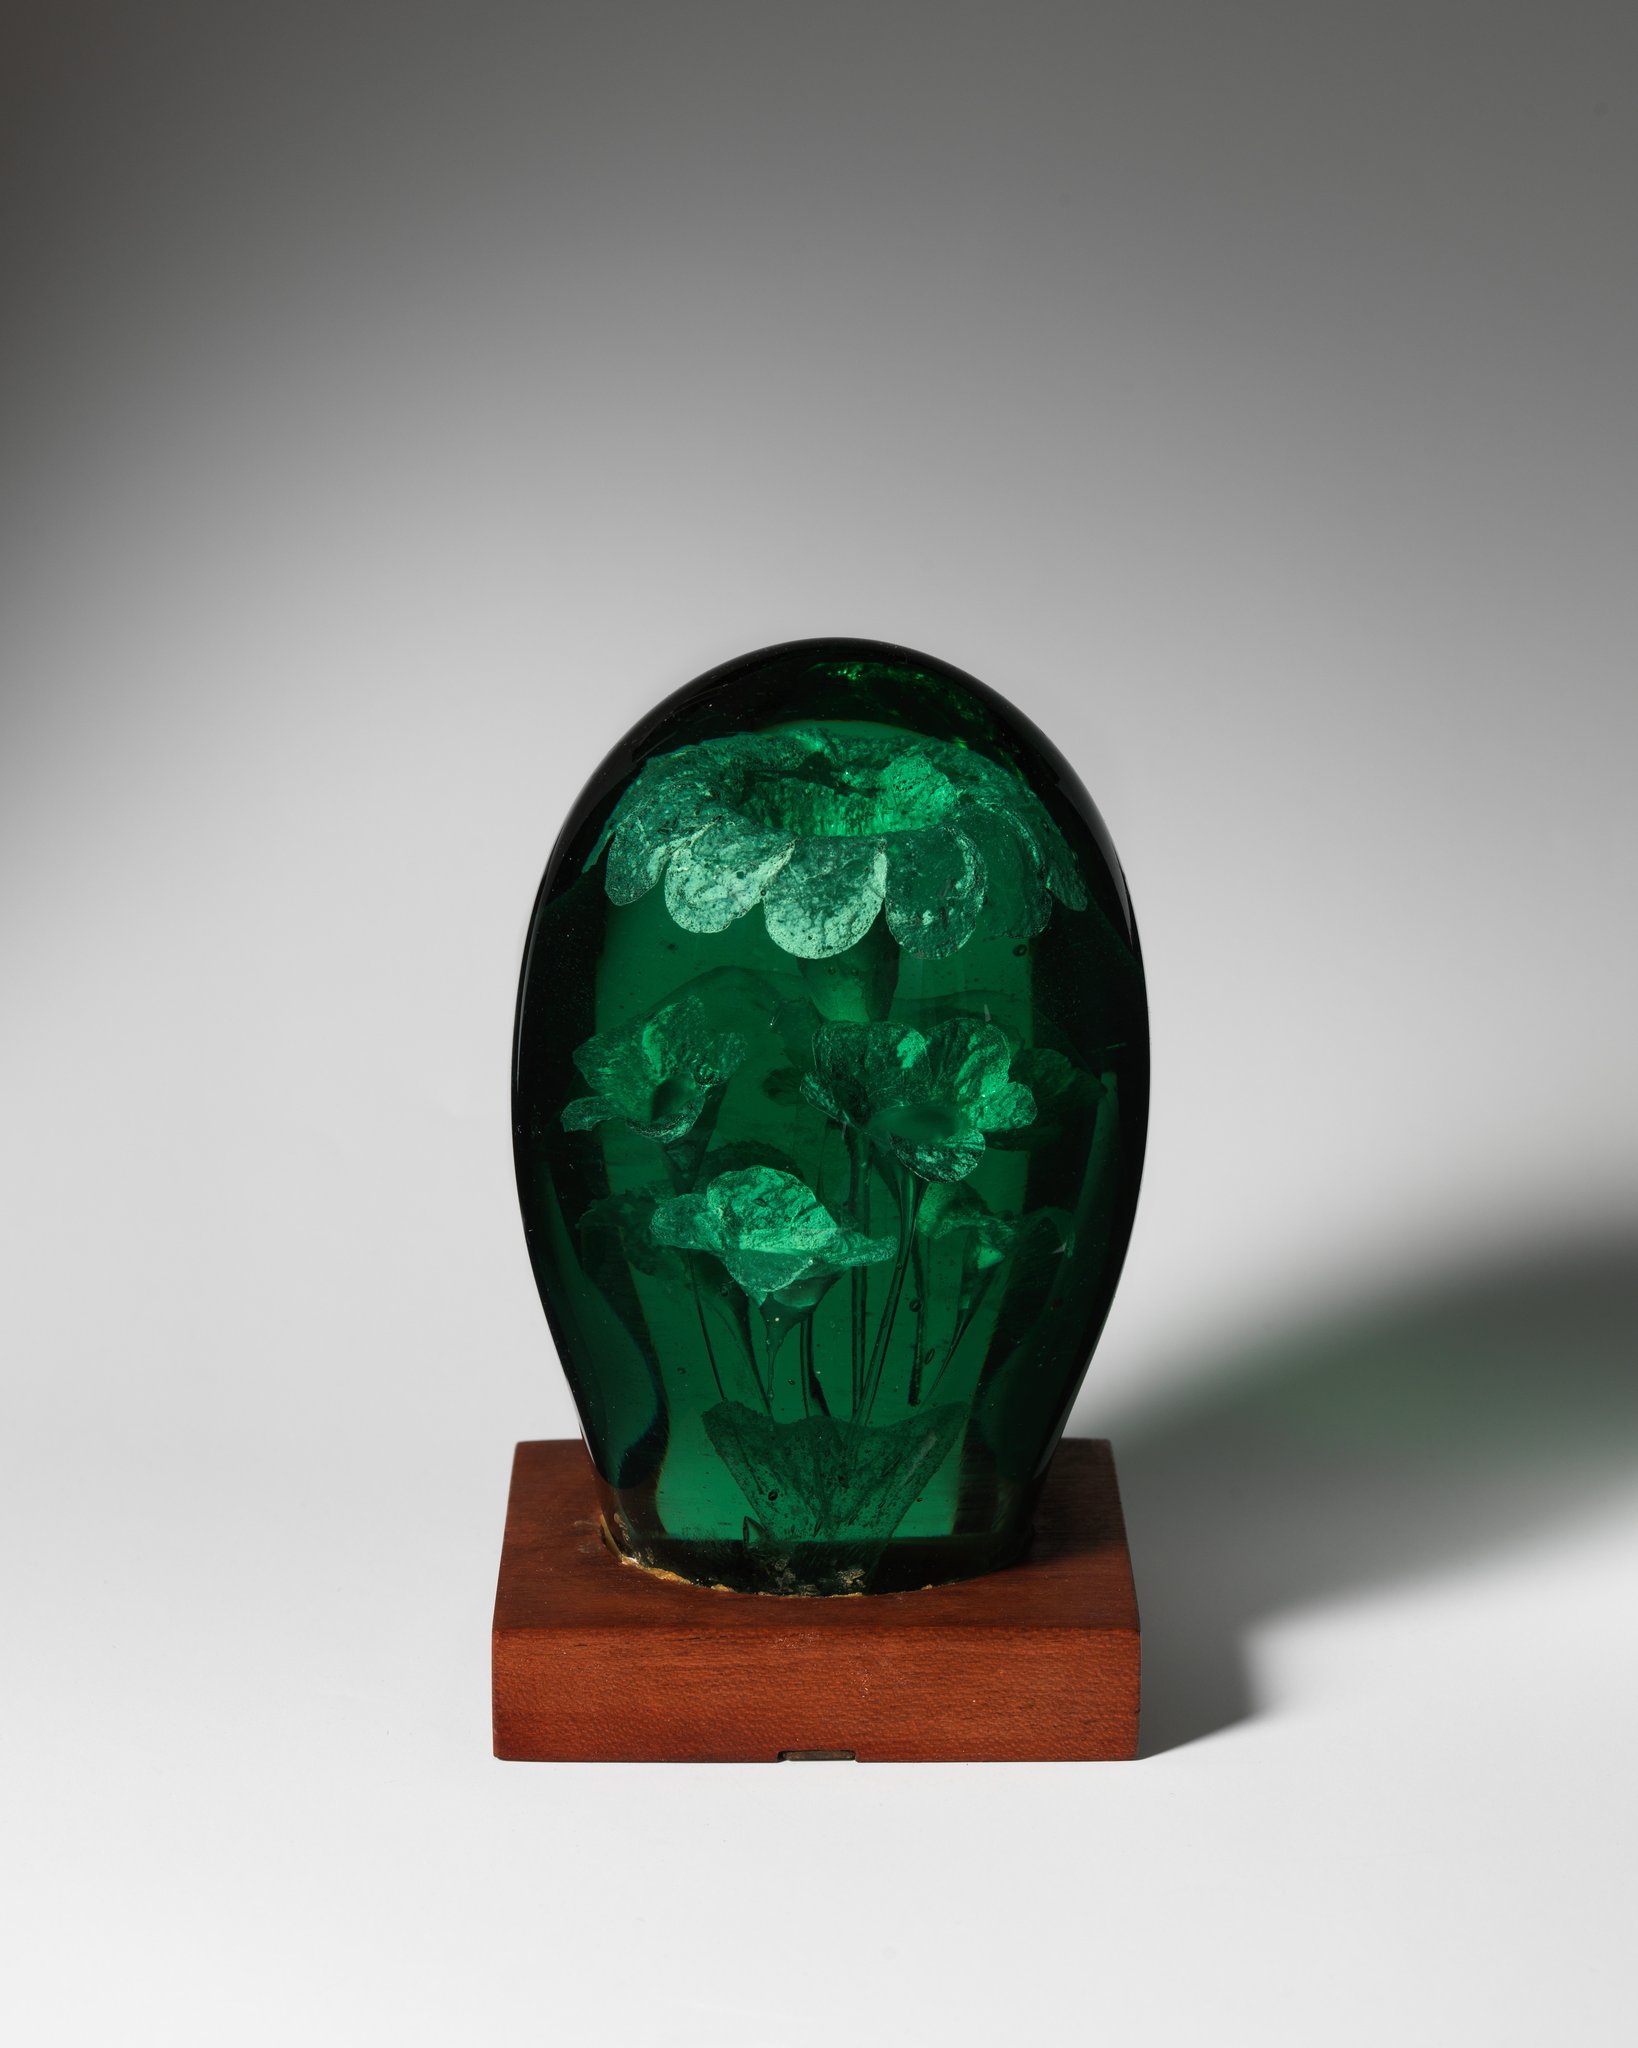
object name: door stop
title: Door stop (one of a pair)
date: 1801-1900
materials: glass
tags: flowers